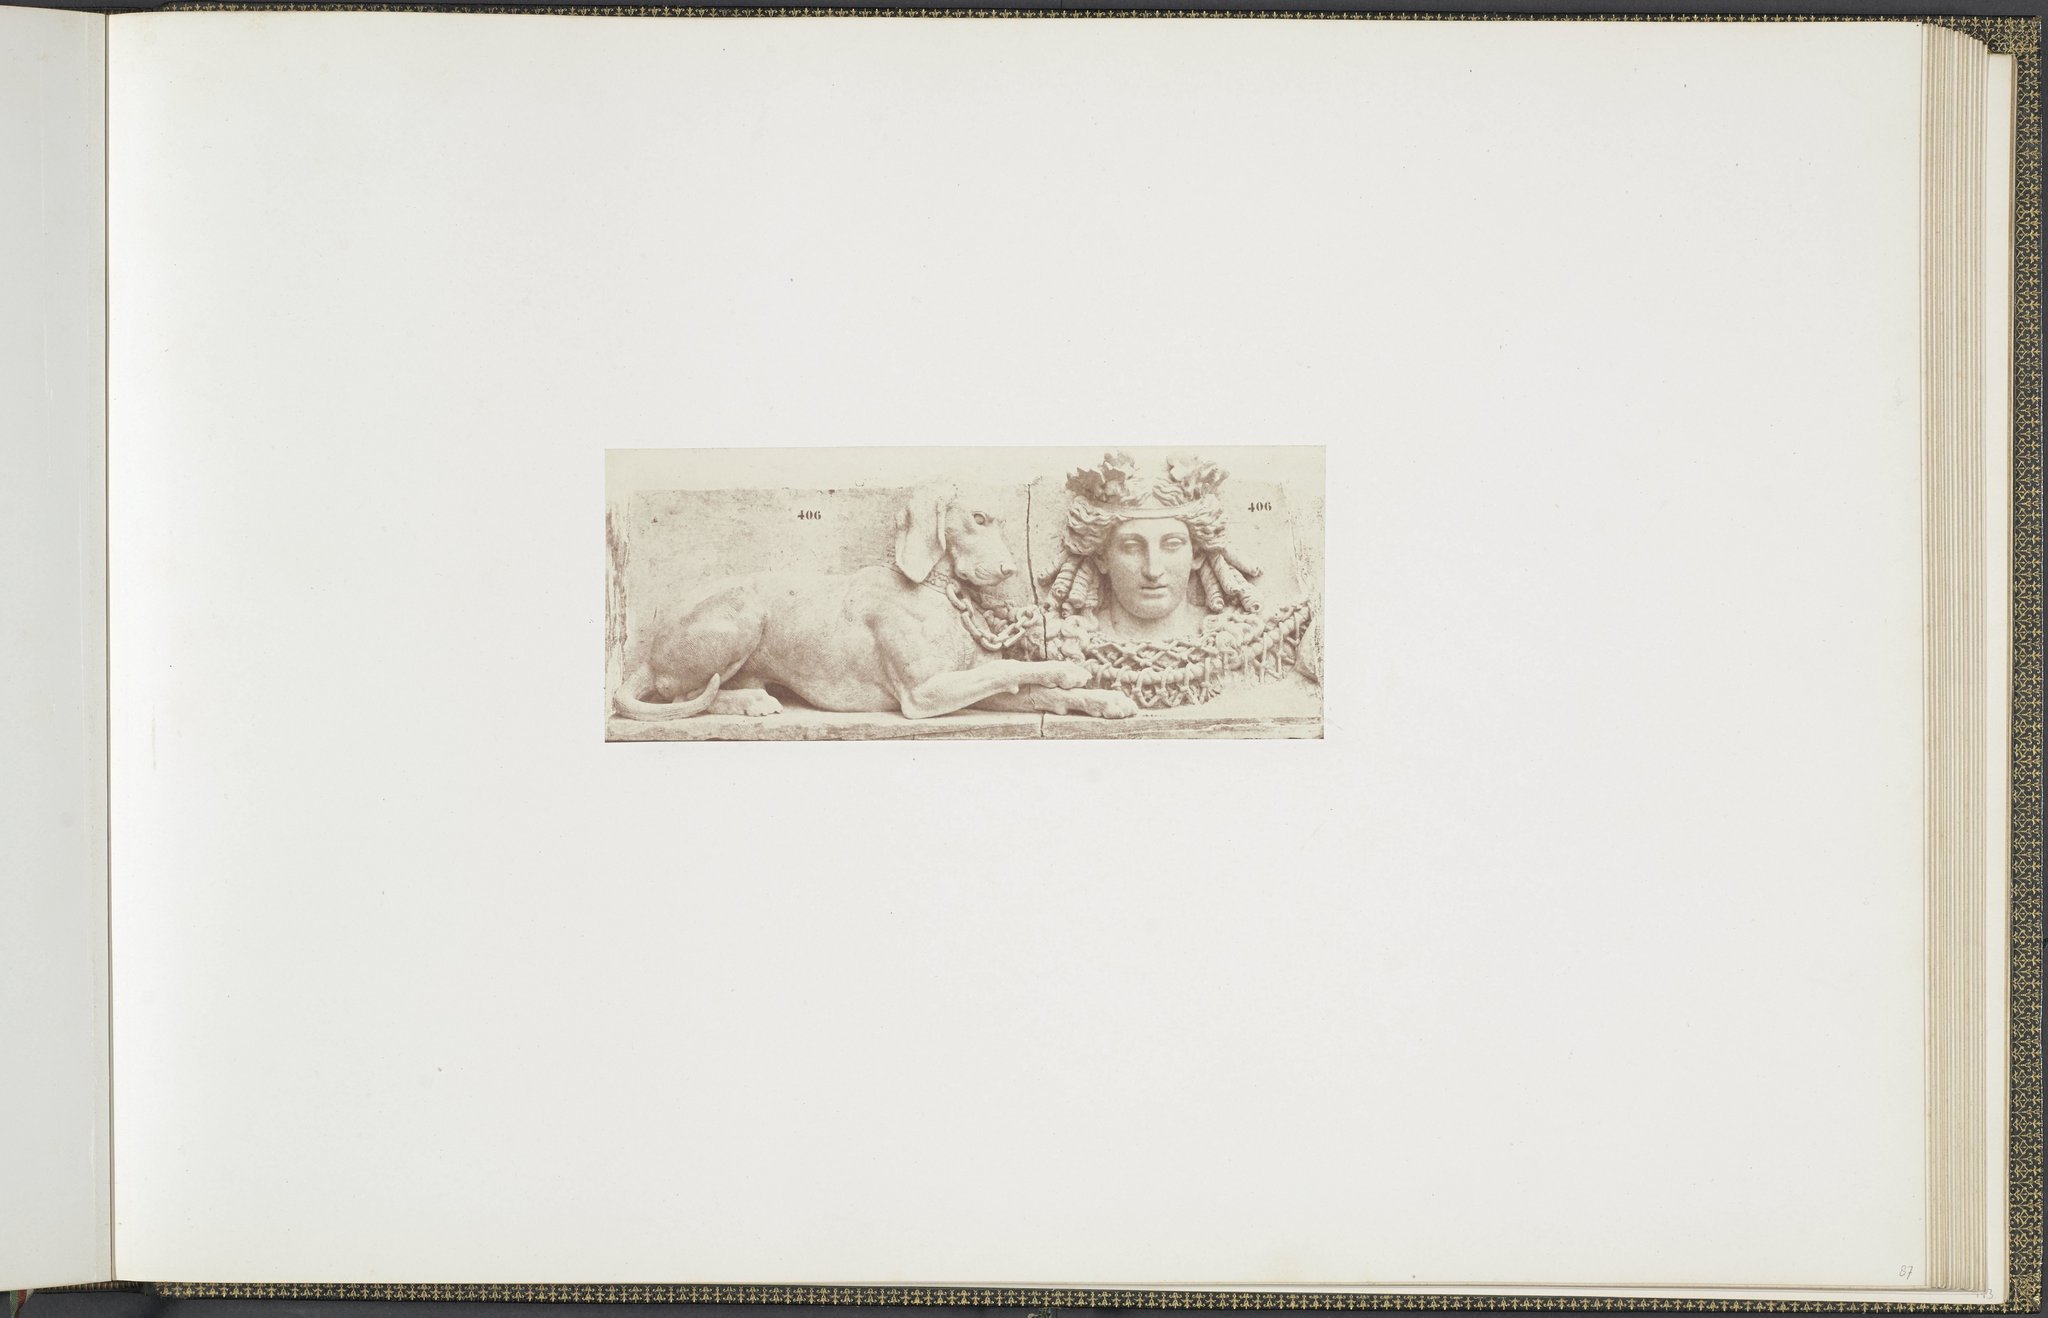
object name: photograph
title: Gipsmodel voor beeldhouwwerk op zolderverdieping van het Pavillon Richelieu van het Palais du Louvre door Pierre Louis Rouillard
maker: édouard denis baldus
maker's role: fotograaf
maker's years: 1813-1889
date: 1855-1857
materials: paper, photographic support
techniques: salted paper print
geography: paris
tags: permanent exhibition, museum, ornamenting, decorating ~ applied arts, paris, tuileries palace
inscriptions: number: ‘406’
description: Onderdeel van Réunion des Tuileries au Louvre 1852-1857, album 1.